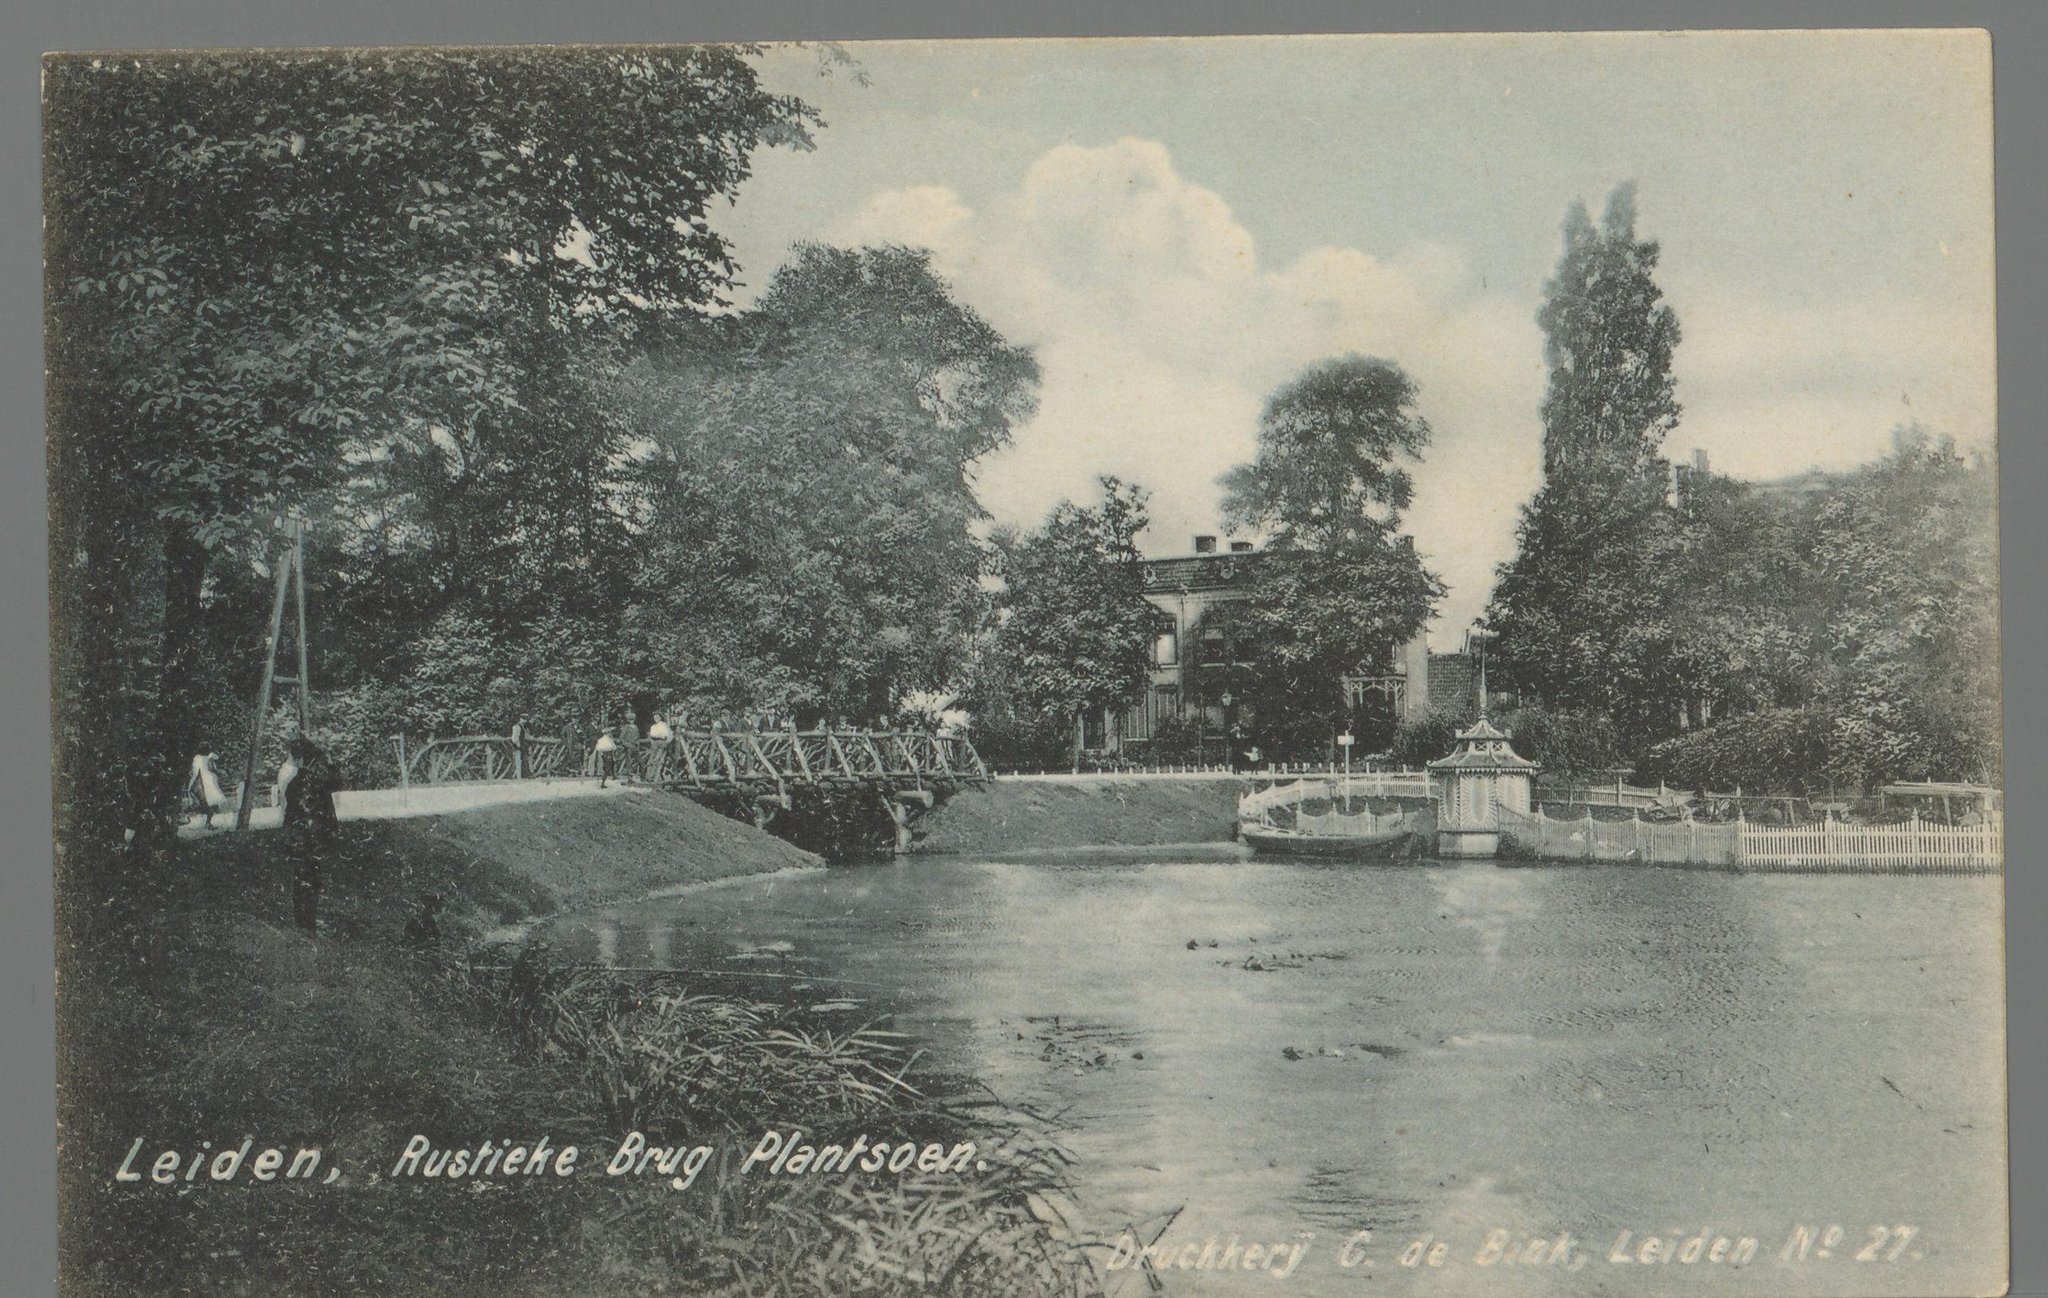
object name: ansichtkaart, prentbriefkaart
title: Leiden, Rustieke Brug Plantsoen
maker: Anonymous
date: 1892-1905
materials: cardboard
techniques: photograph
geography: leiden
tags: canal, bridge in city across river, canal, etc.